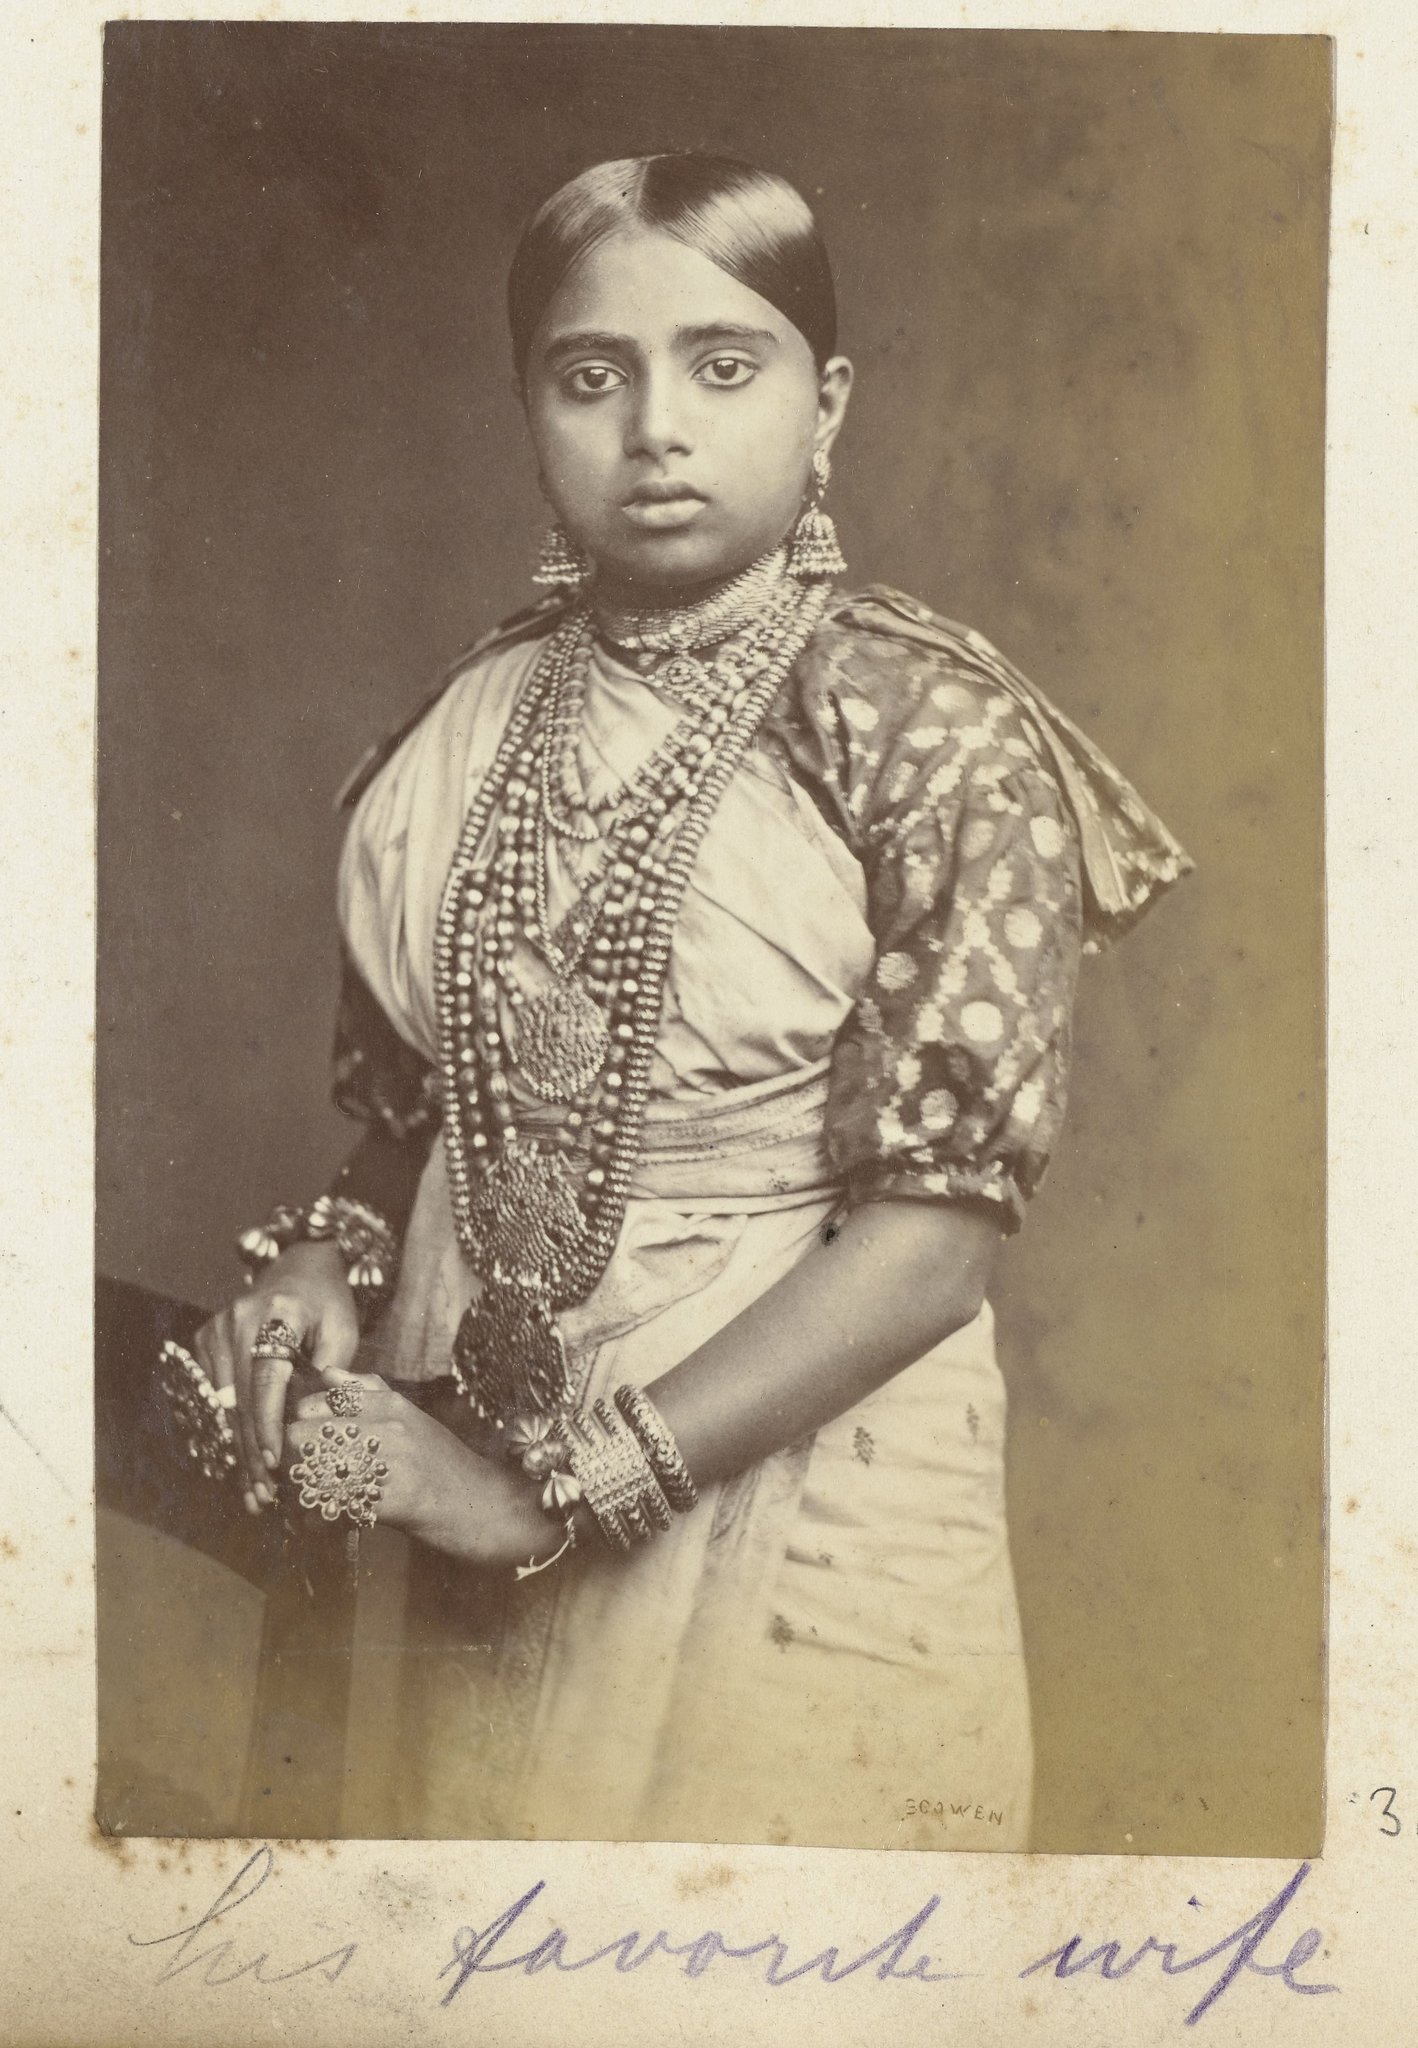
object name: photograph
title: His favorite wife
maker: Anonymous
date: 1890-1910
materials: cardboard, paper, photographic support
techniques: gelatin silver print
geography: colombo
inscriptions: caption: ‘His favorite wife’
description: De vrouw is mogelijk een van de vrouwen van de koning van Rauden